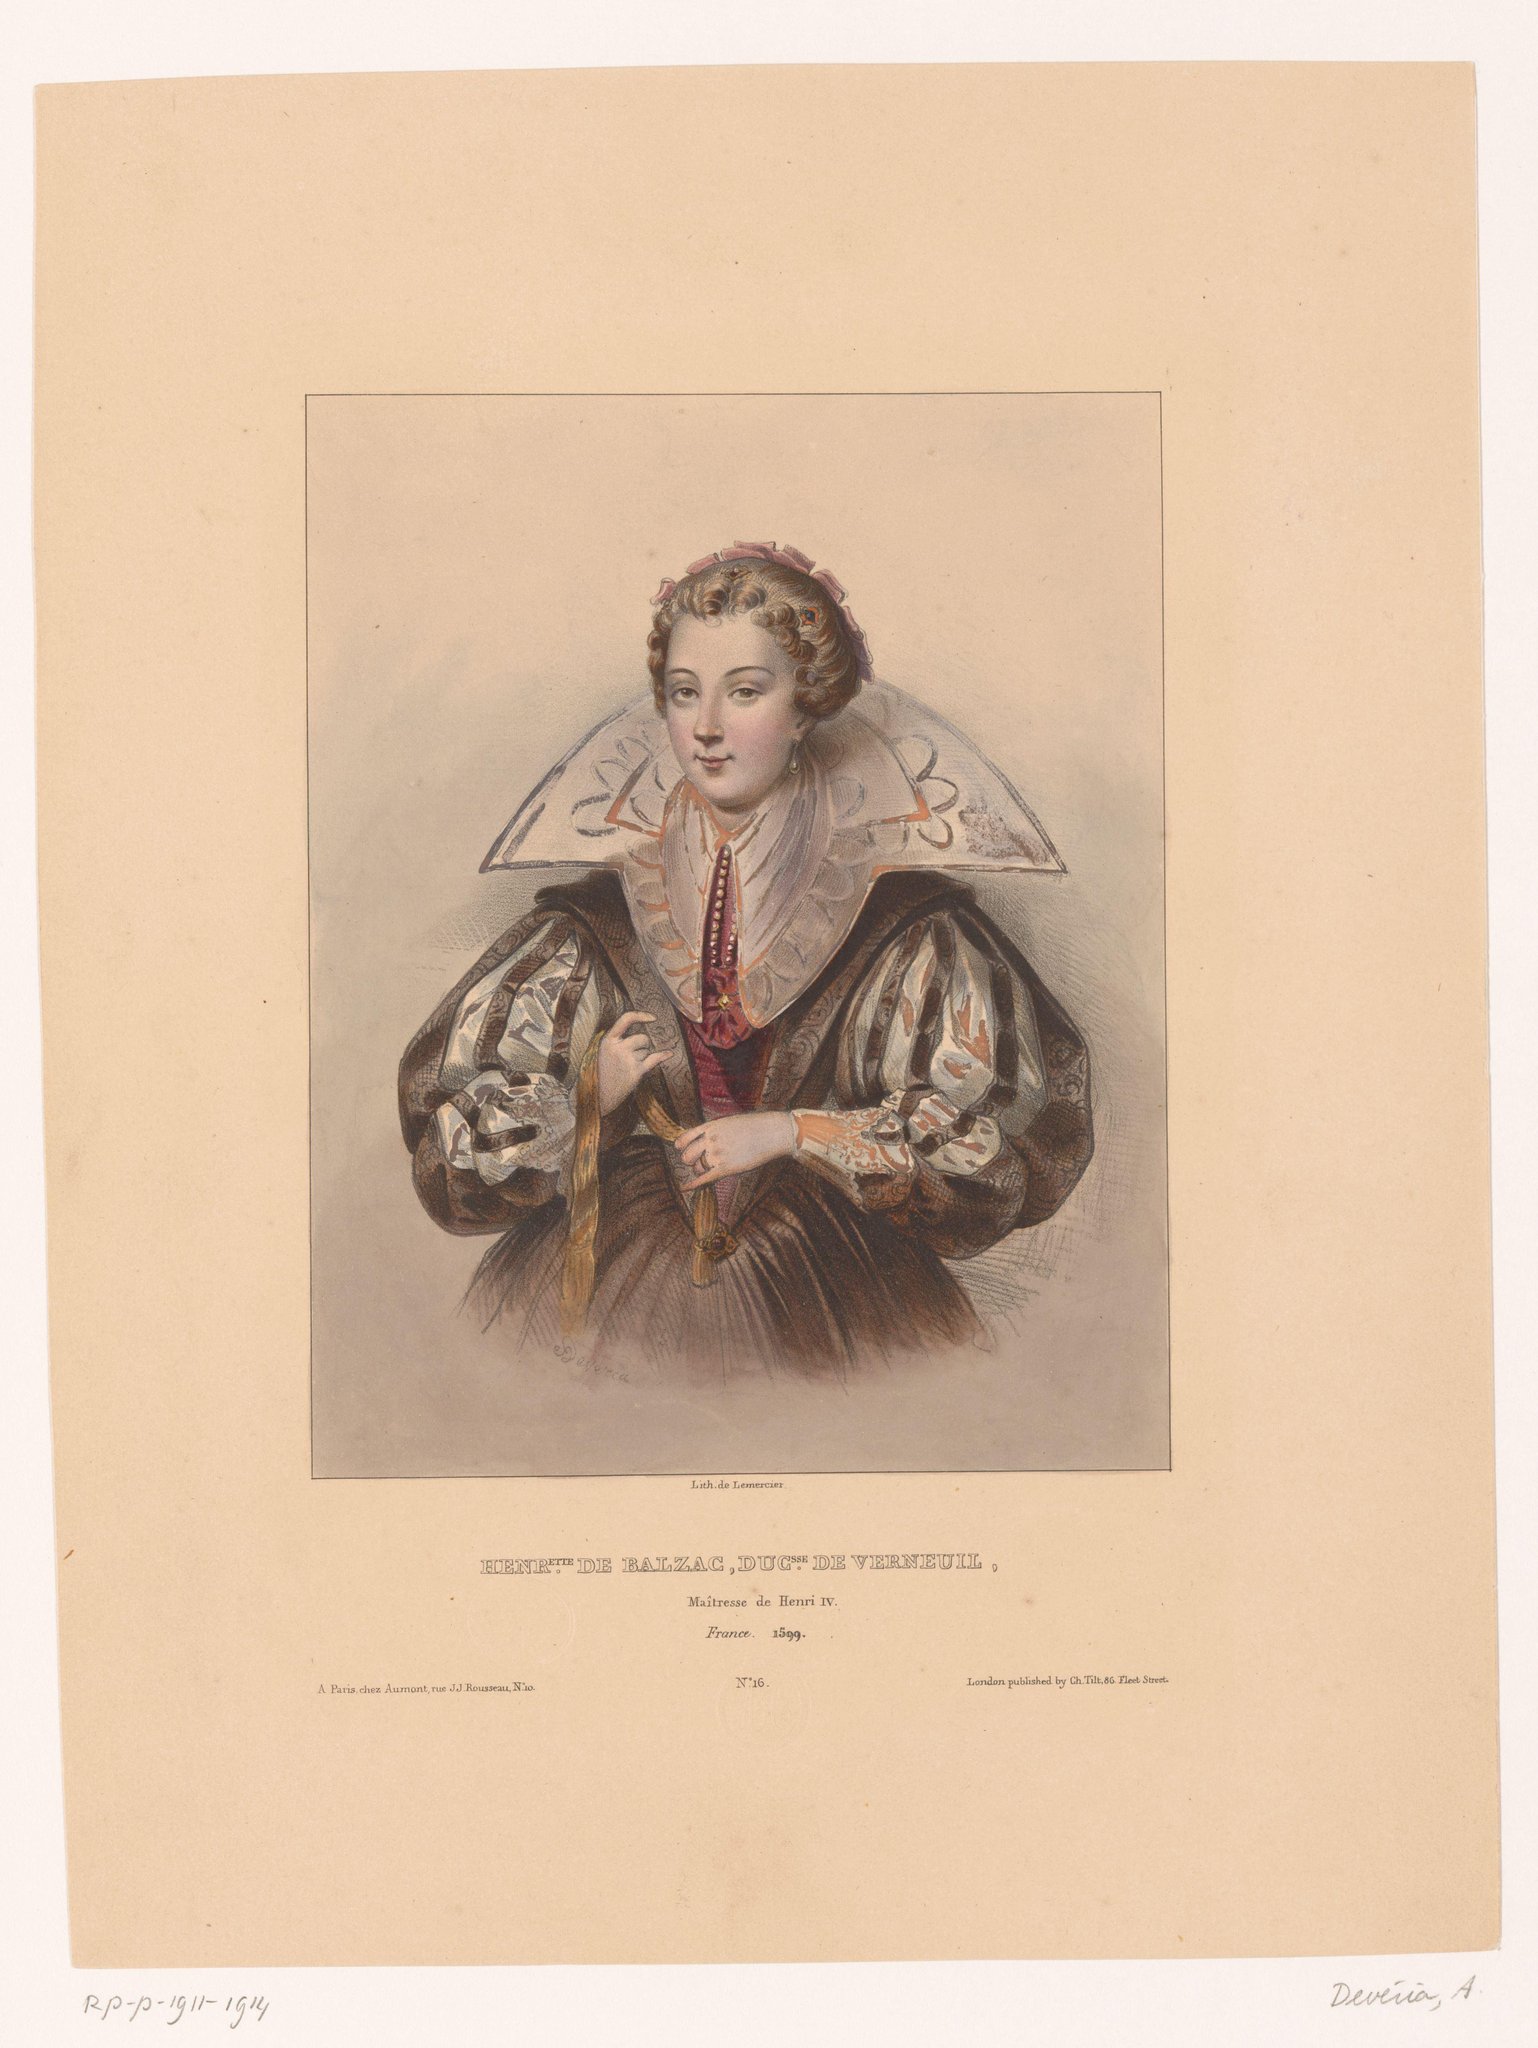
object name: print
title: Portret van Catherine Henriette de Balzac d'Entragues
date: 1832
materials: paper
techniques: hand coloring, lithograph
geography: paris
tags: paris, historical persons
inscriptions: check stamp: Lugt 3987, collector's mark: Lugt 2228a, check stamp: Lugt 88b